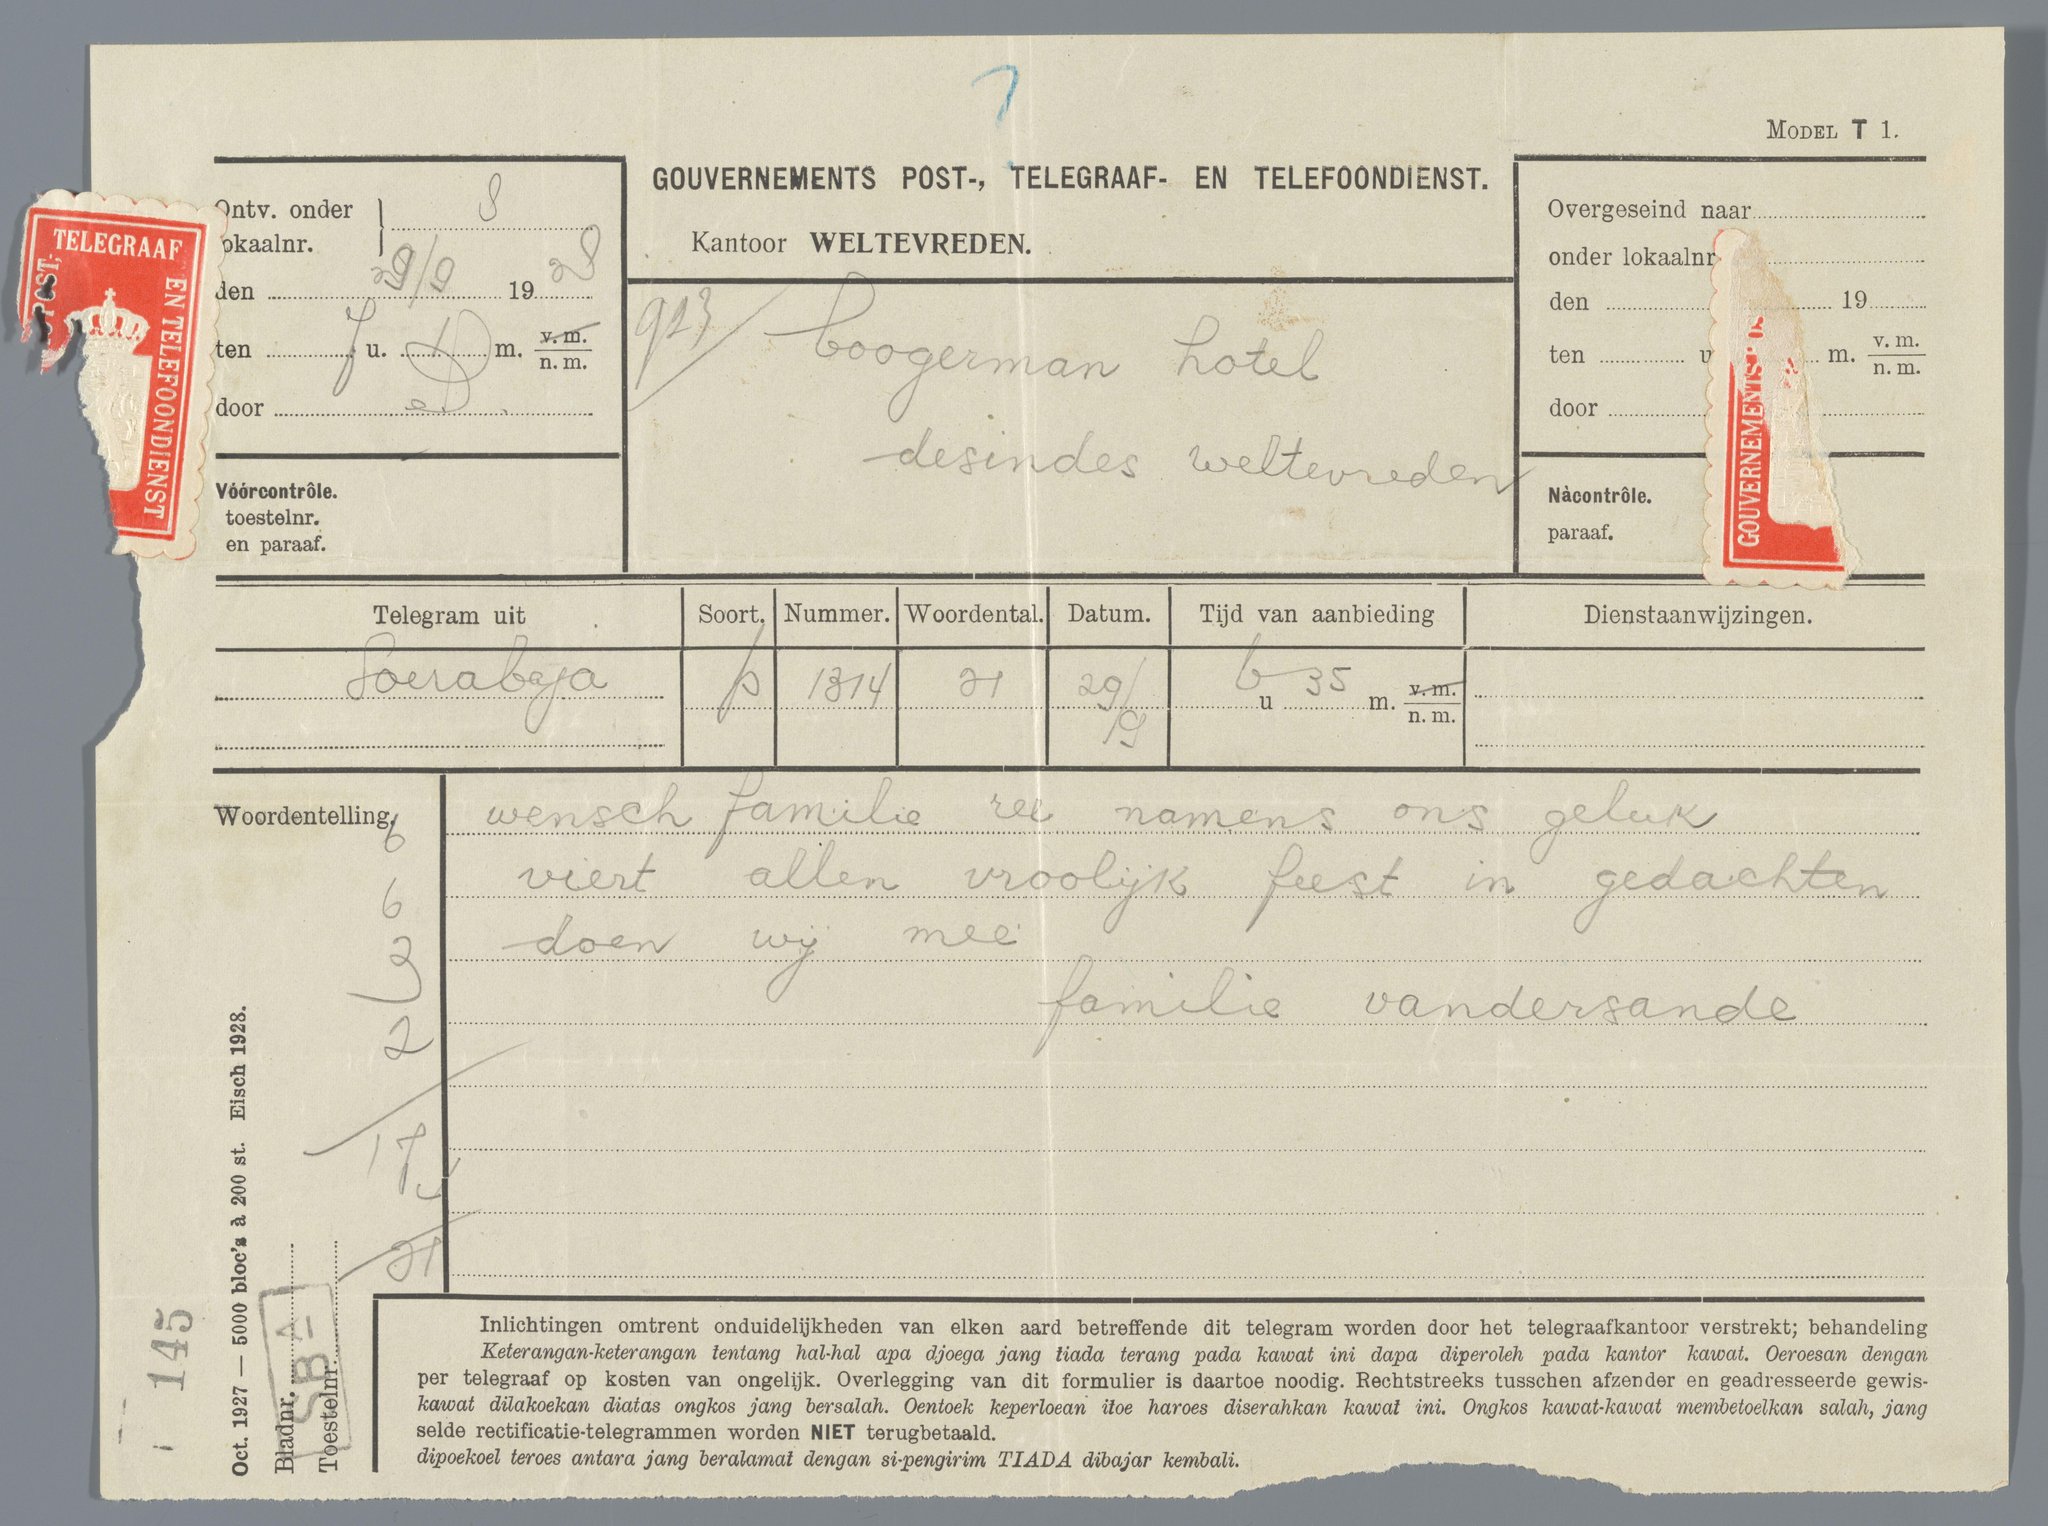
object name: telegram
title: Telegram met gelukwensen, 1928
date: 1928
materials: paper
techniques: typewriting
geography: weltevreden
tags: batavia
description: Telegram met gelukwensen namens de familie VanderSande, verzonden vanuit Soerabaja op 29 september 1928. Document van Gouvernements Post-, Telegraaf- en Telefoondienst, kantoor Weltevreden, met gedrukte en getypte tekst, stempels en een verbroken zegel. Behoort bij het herinneringsalbum aangeboden aan Willem Ree van accountantsbureau Frese & Hogeweg bij zijn vertrek bij het kantoor in Weltevreden op 30 september 1928.